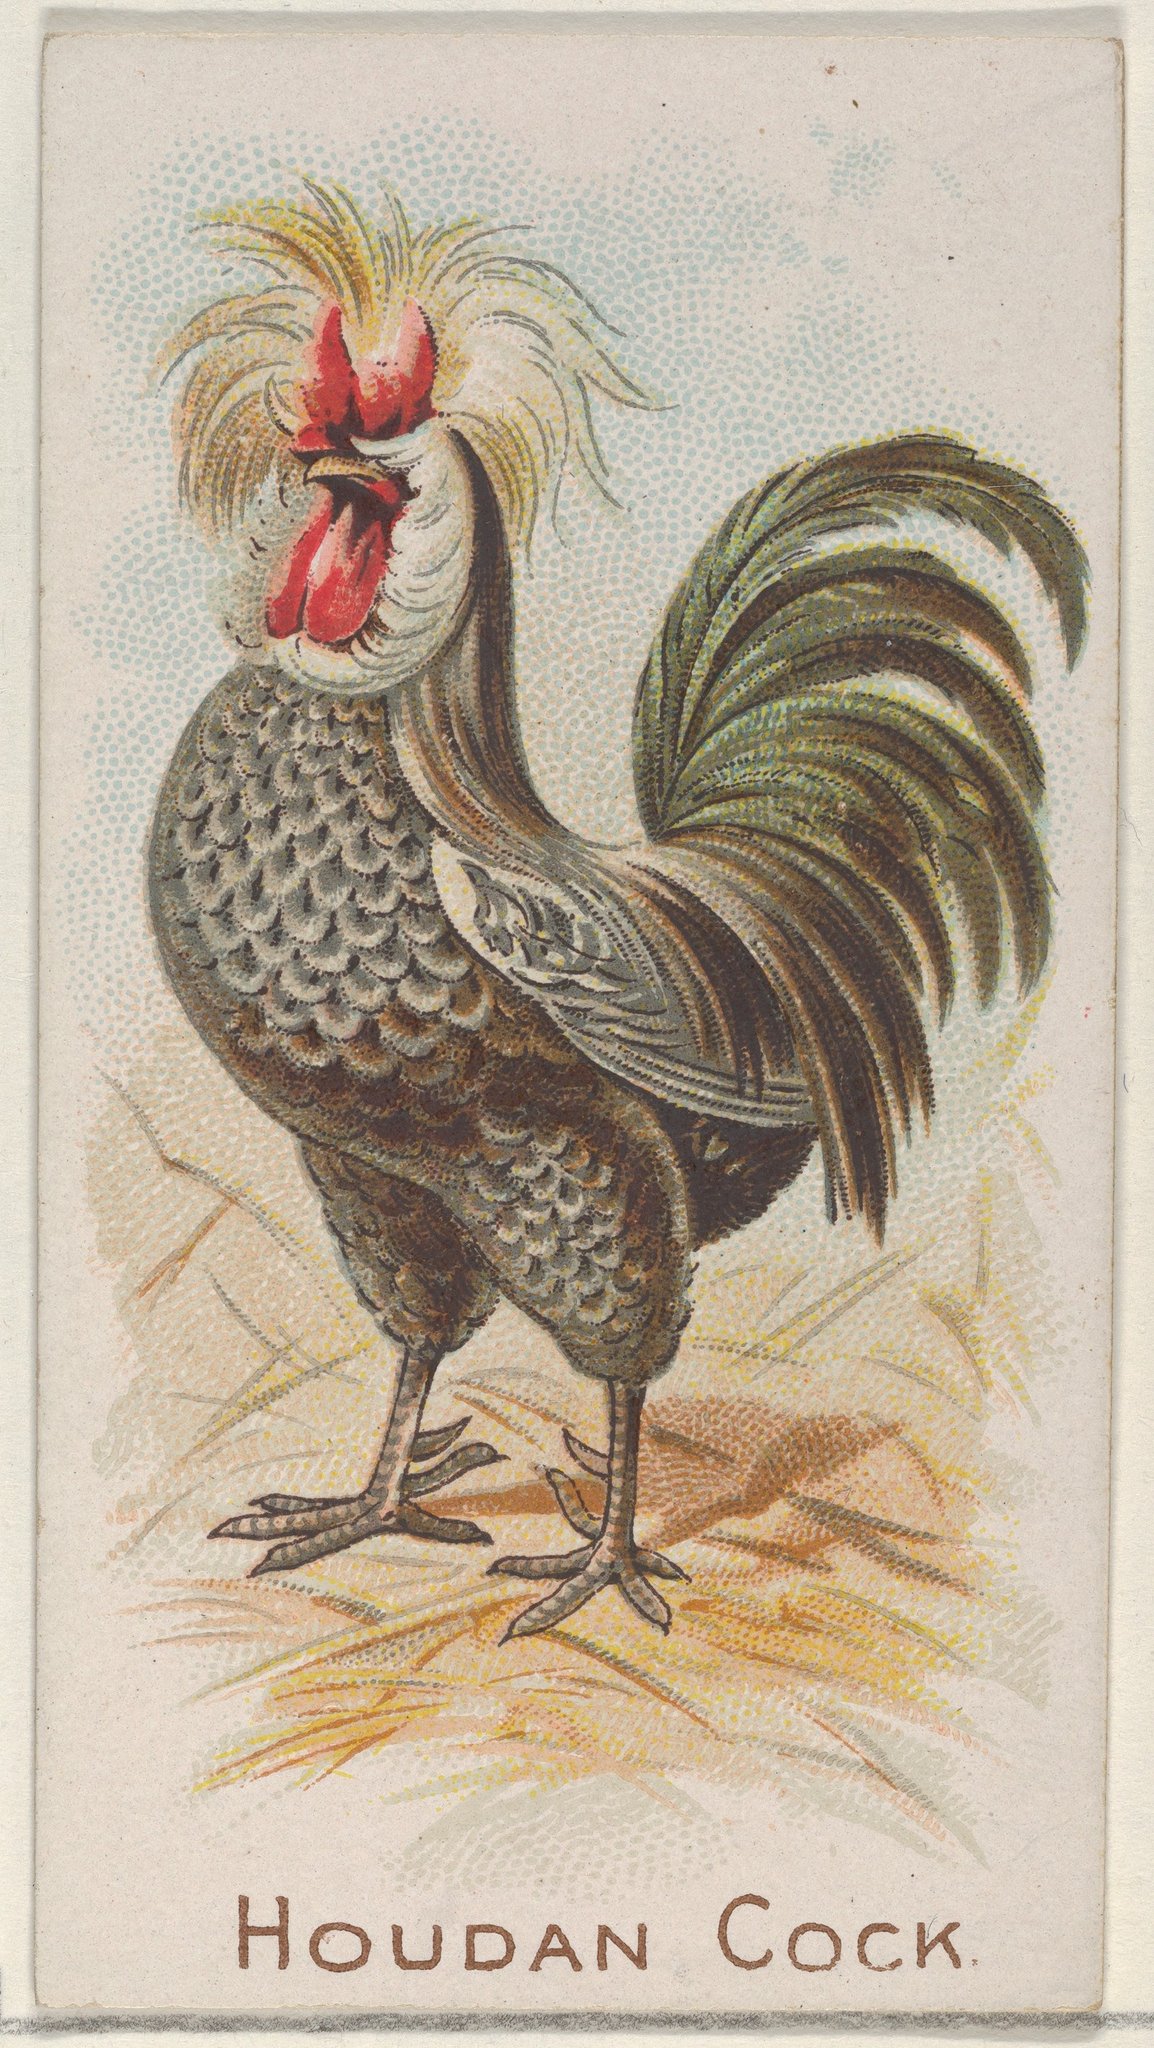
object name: print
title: Houdan Cock, from the Prize and Game Chickens series (N20) for Allen & Ginter Cigarettes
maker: allen & ginter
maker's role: publisher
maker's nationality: american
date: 1891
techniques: color lithograph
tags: roosters